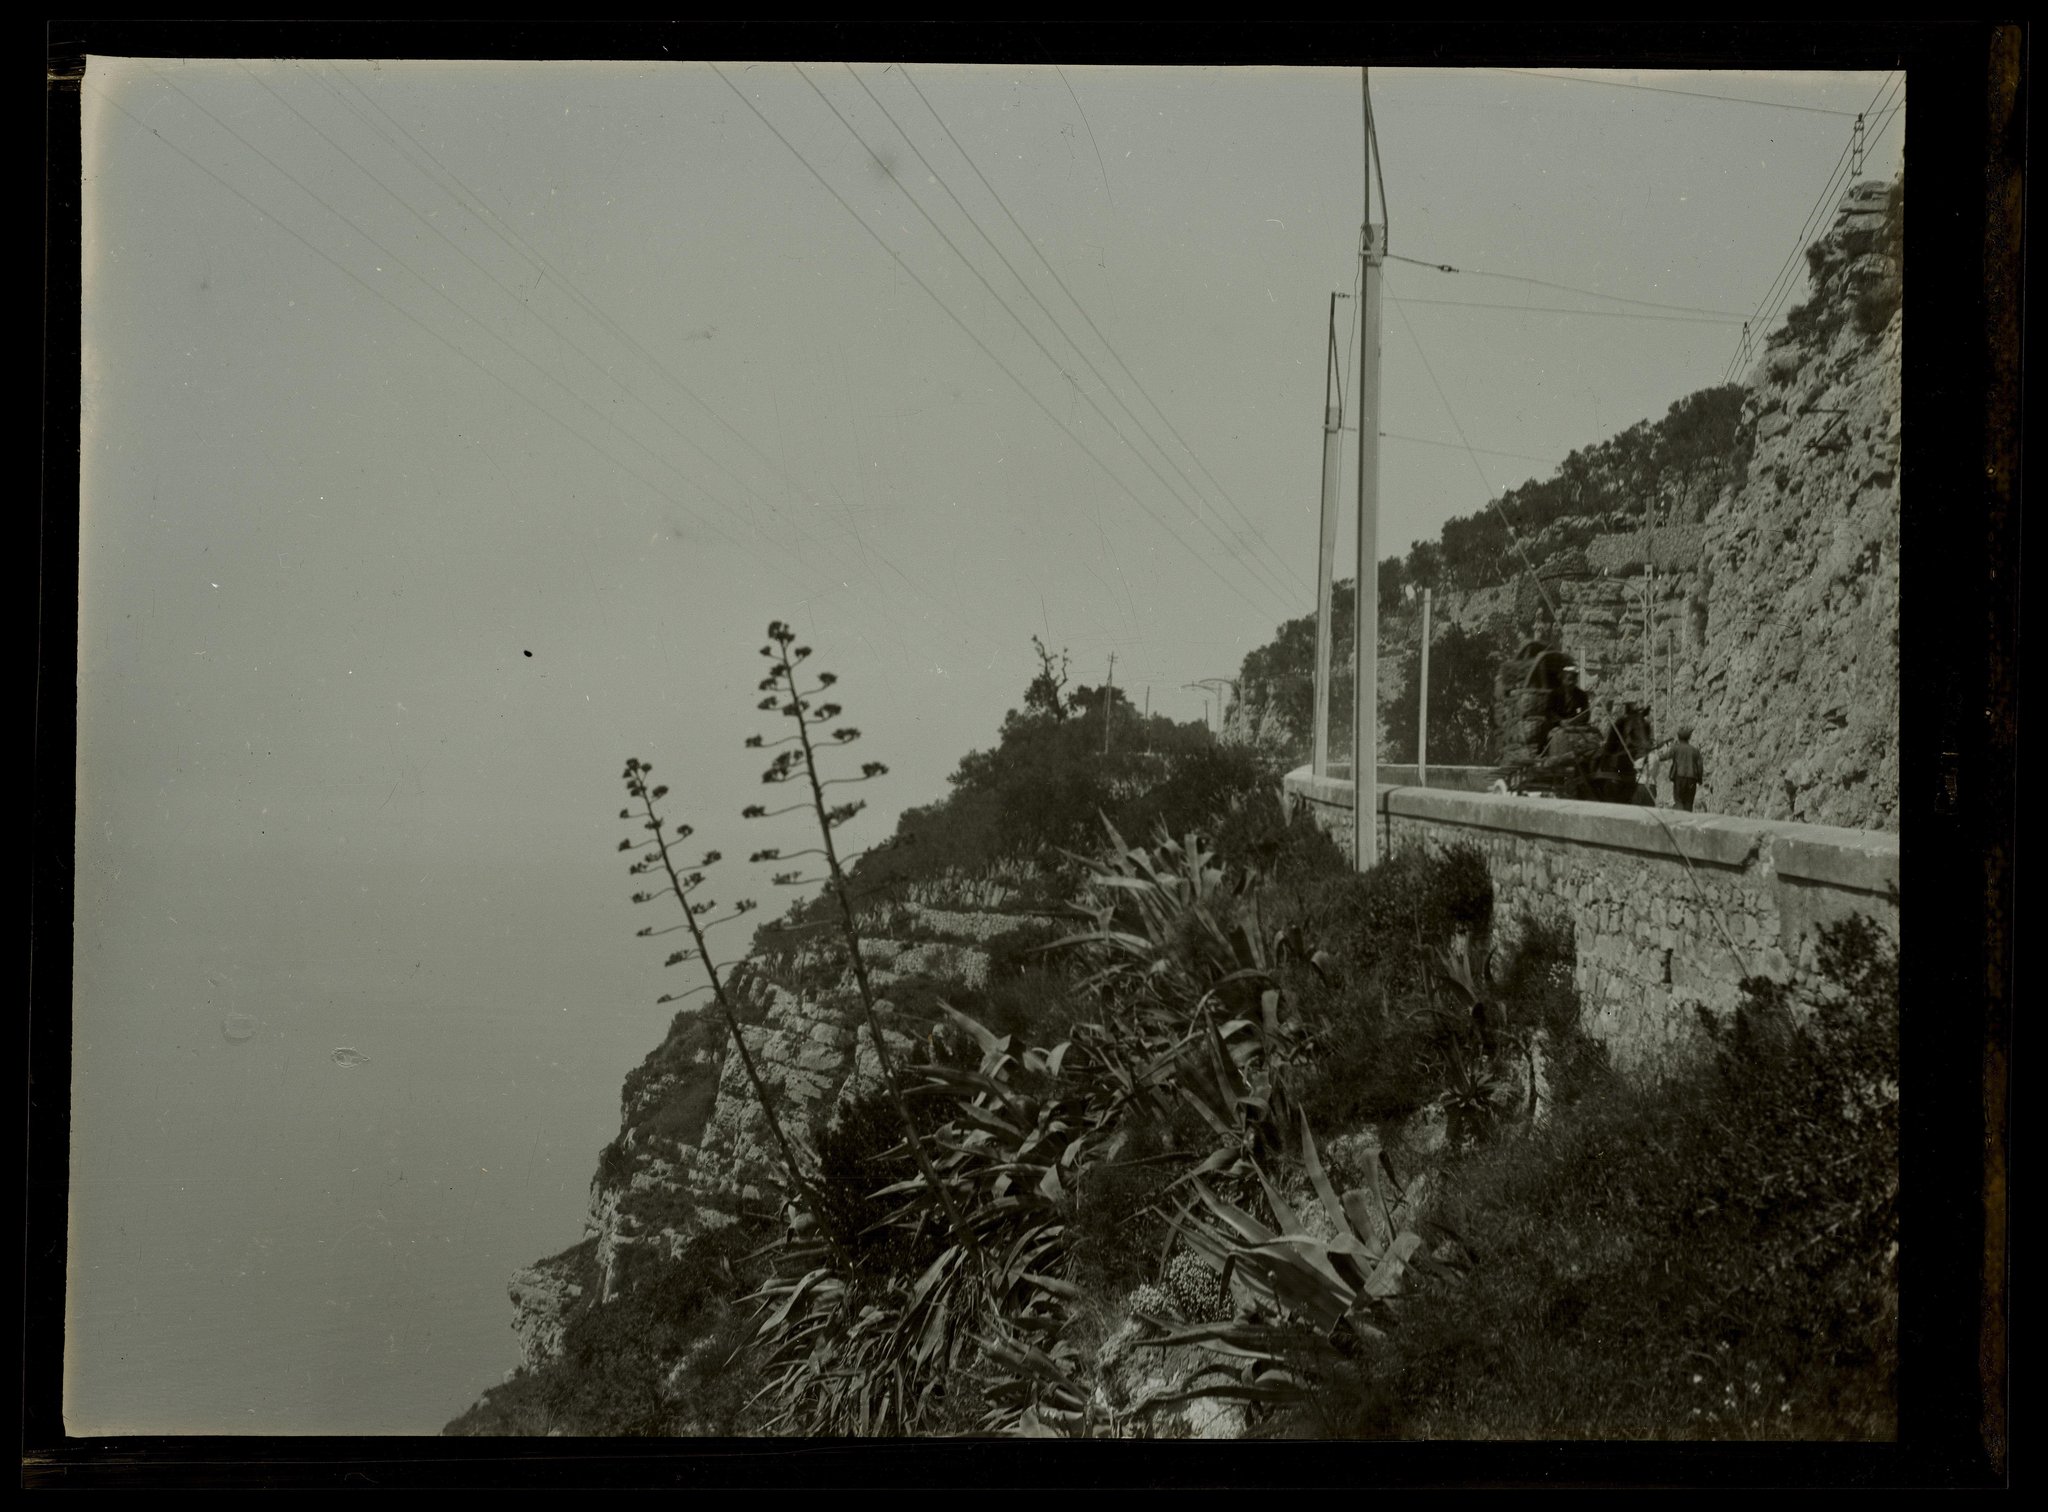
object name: negative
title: Filmnegatief met opname van Napels of omgeving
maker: Anonymous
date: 1907-1935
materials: film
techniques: gelatin silver negative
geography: italy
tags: italy